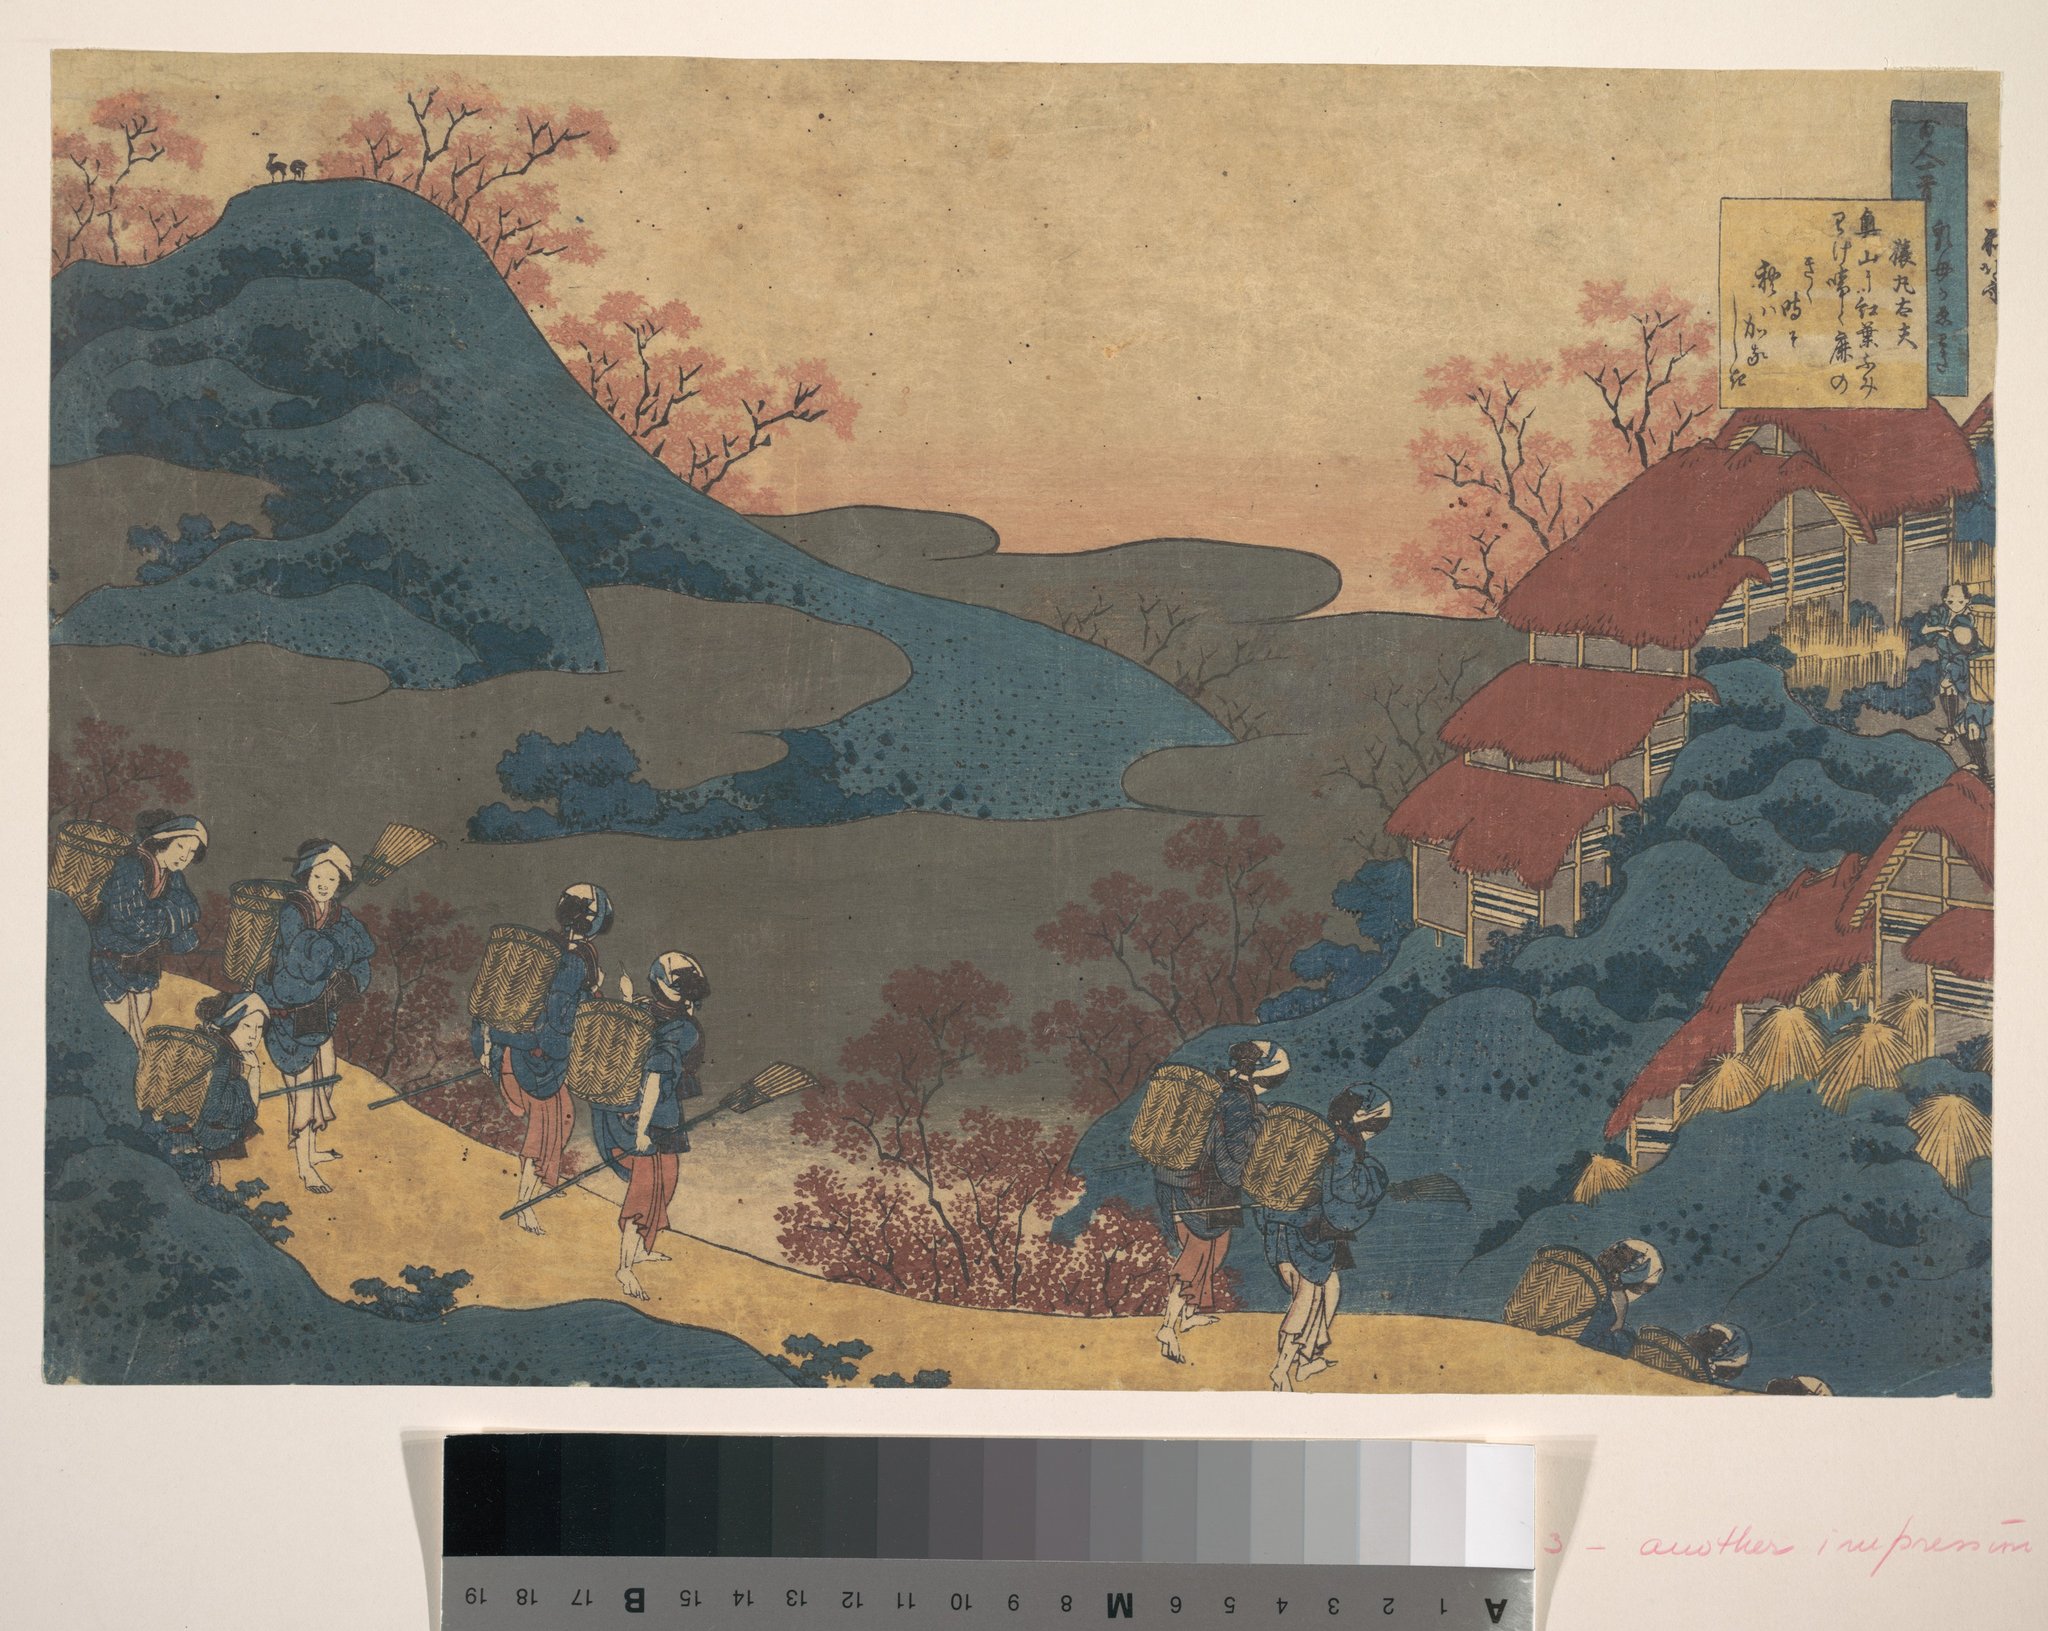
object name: woodblock print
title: Poem by Sarumaru Dayū, from the series One Hundred Poems Explained by the Nurse (Hyakunin isshu uba ga etoki)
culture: japanese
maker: katsushika hokusai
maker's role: artist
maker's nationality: japanese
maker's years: 1760-1849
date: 1839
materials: ink, paper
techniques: woodblock print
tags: human figures,poetry,houses,mountains,trees